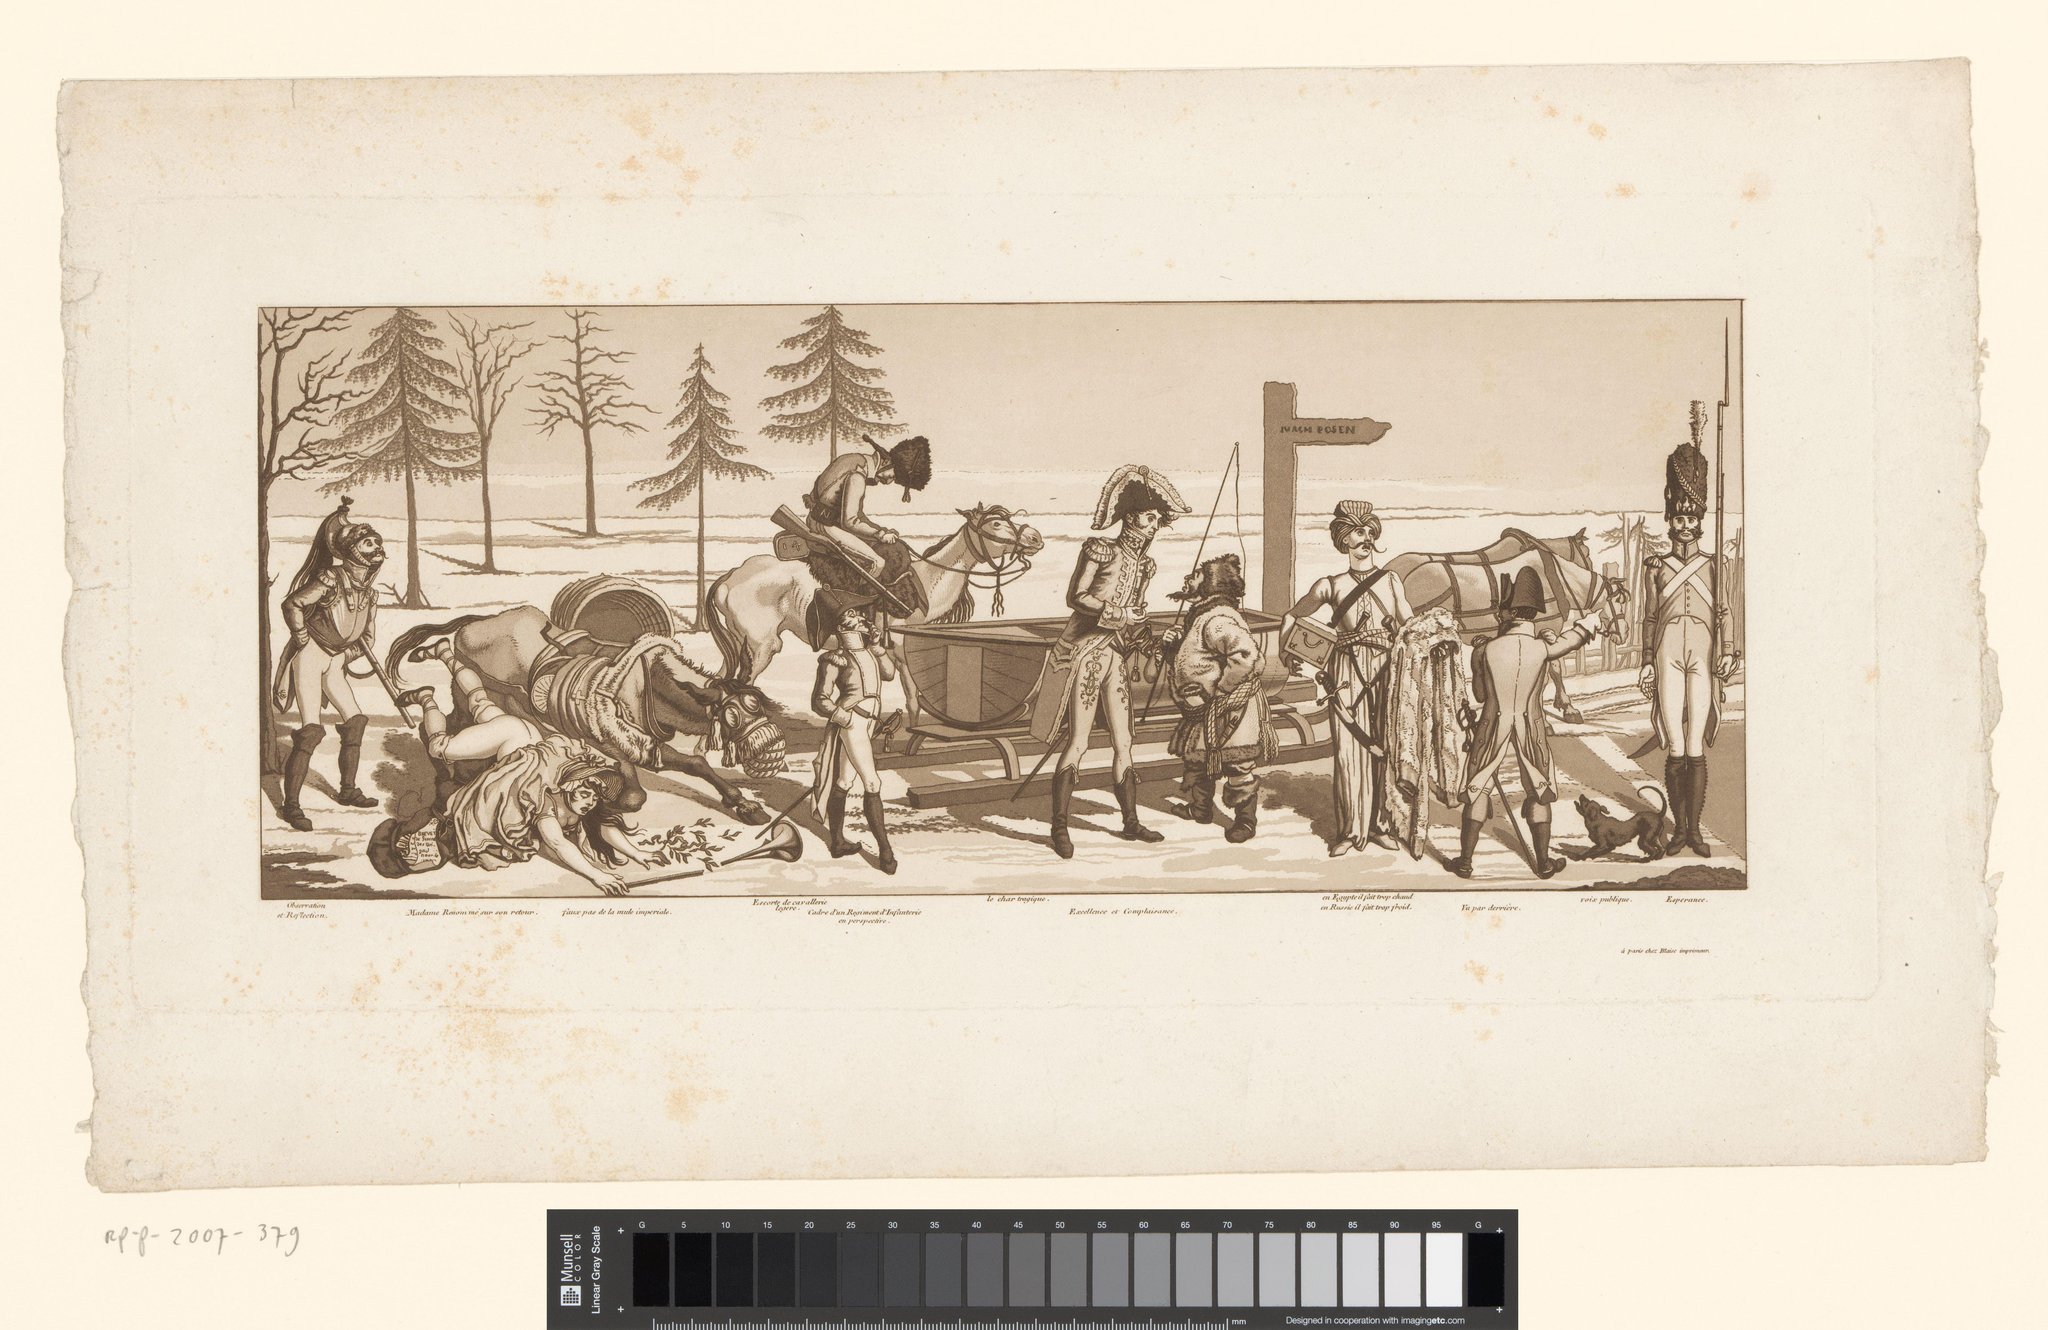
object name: print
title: La Retraite de la Renommée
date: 1813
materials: paper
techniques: aquatint, etching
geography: paris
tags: retreat of the defeated, political caricatures and satires, russia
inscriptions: collector's mark: Lugt 2760, collector's mark: Lugt 2228